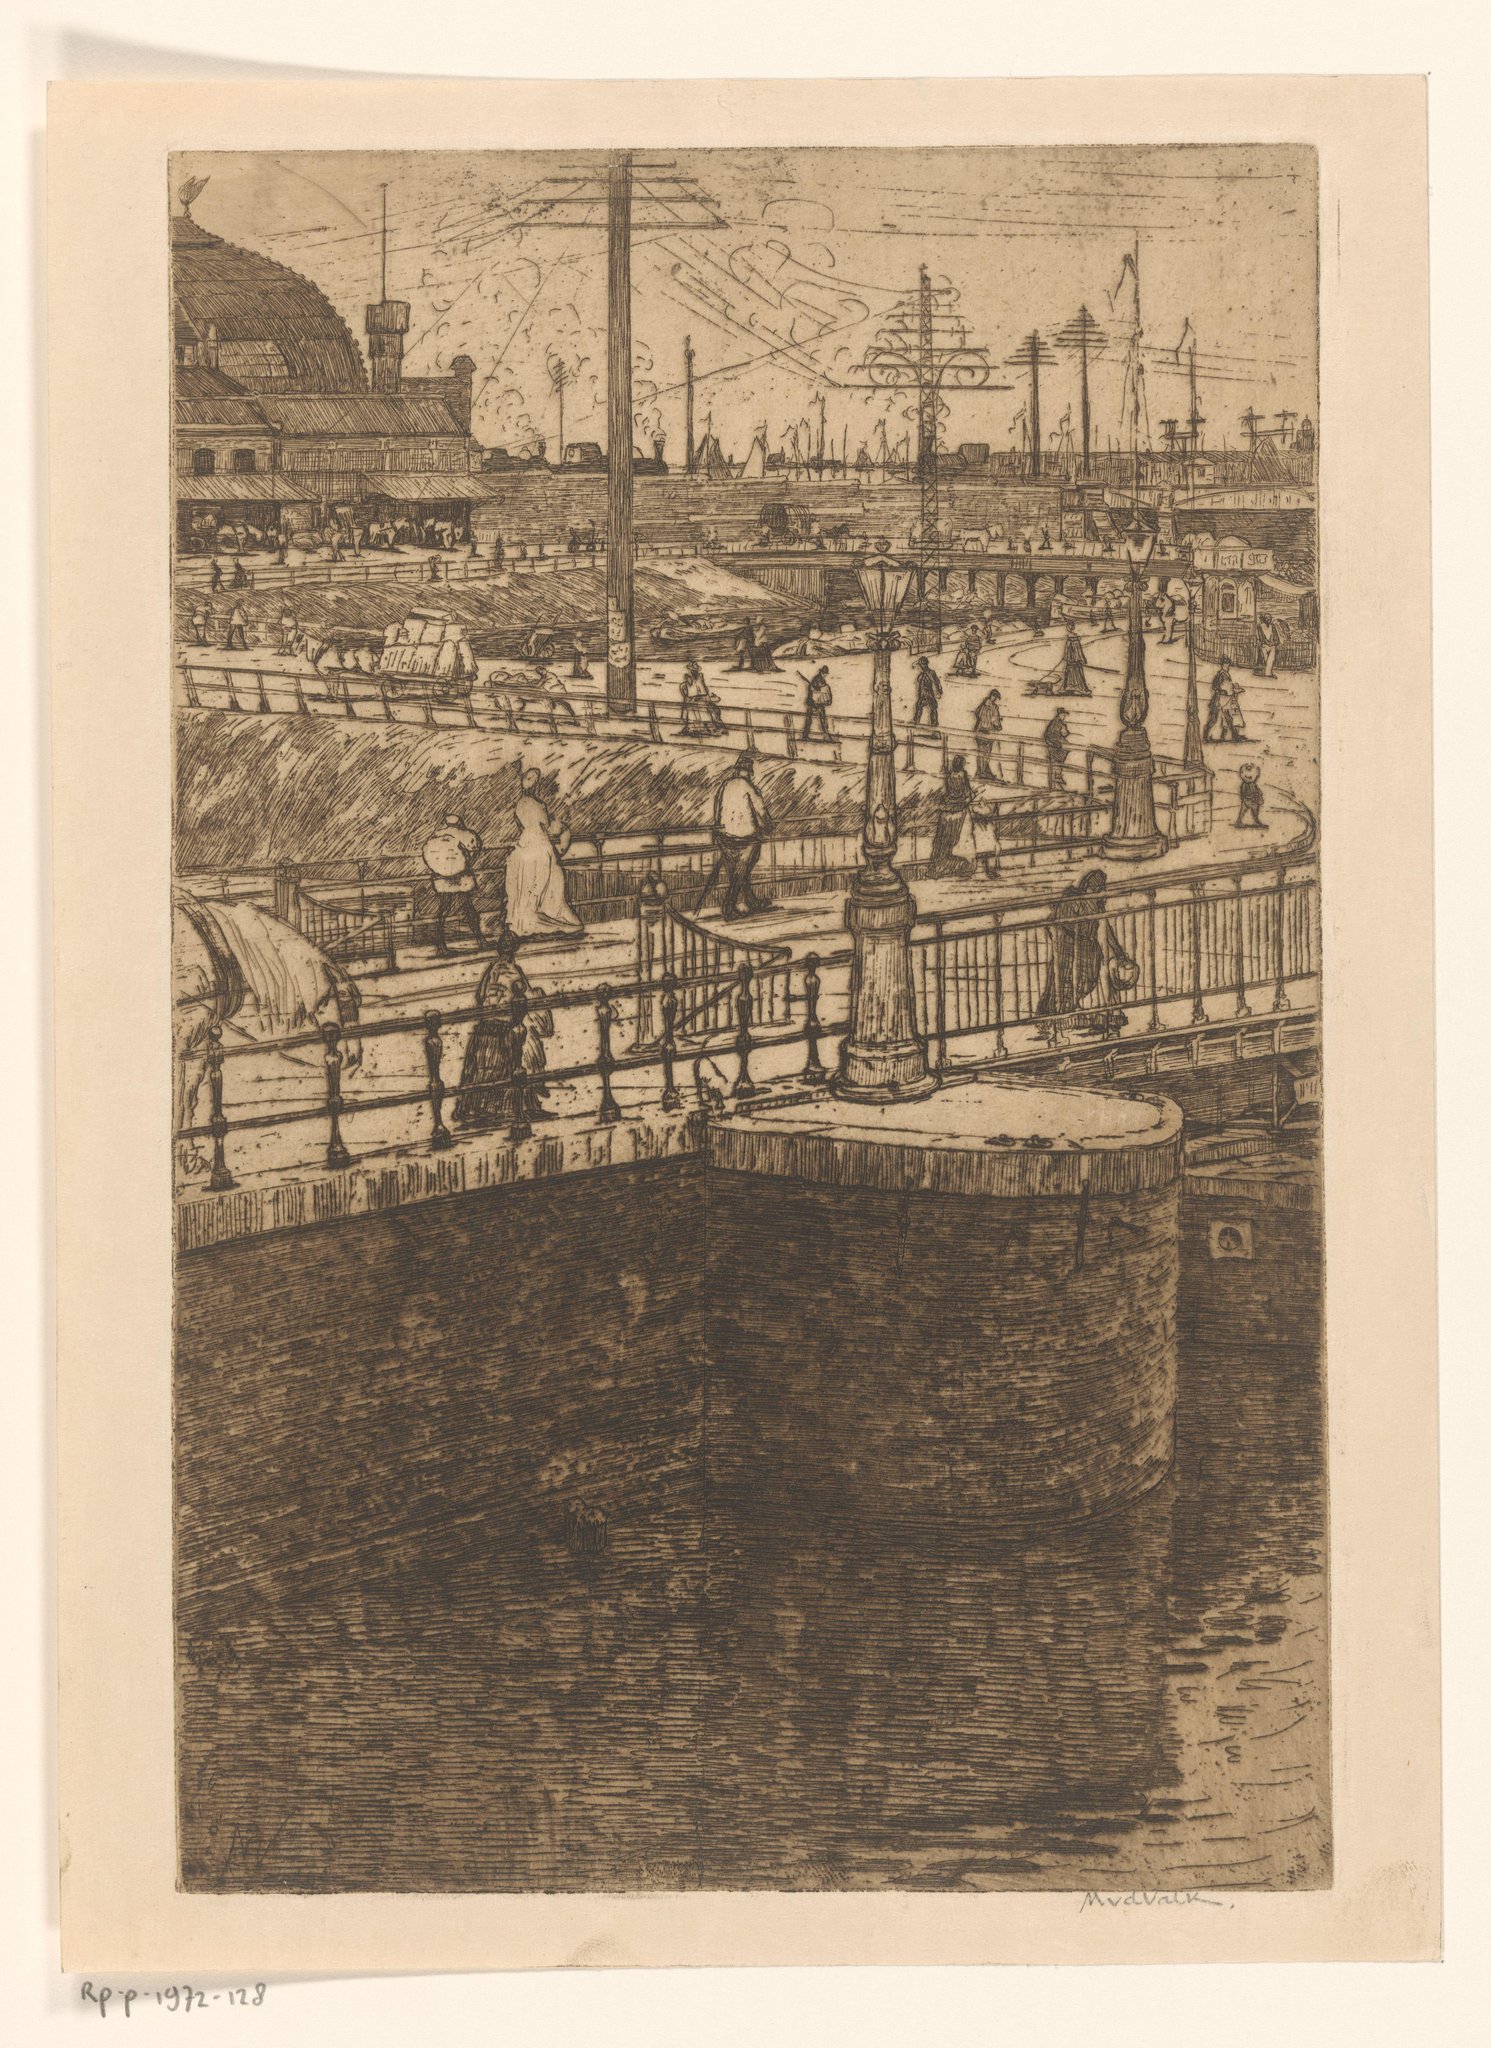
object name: print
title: Brug bij Station Amsterdam Centraal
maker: maurits van der valk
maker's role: draughtsman, print maker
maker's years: 1857-1935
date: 1886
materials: paper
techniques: drypoint, etching, intaglio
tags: station; shelter (railway, tramway), bridge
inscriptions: collector's mark: Lugt 2228, collector's mark: Lugt 2760